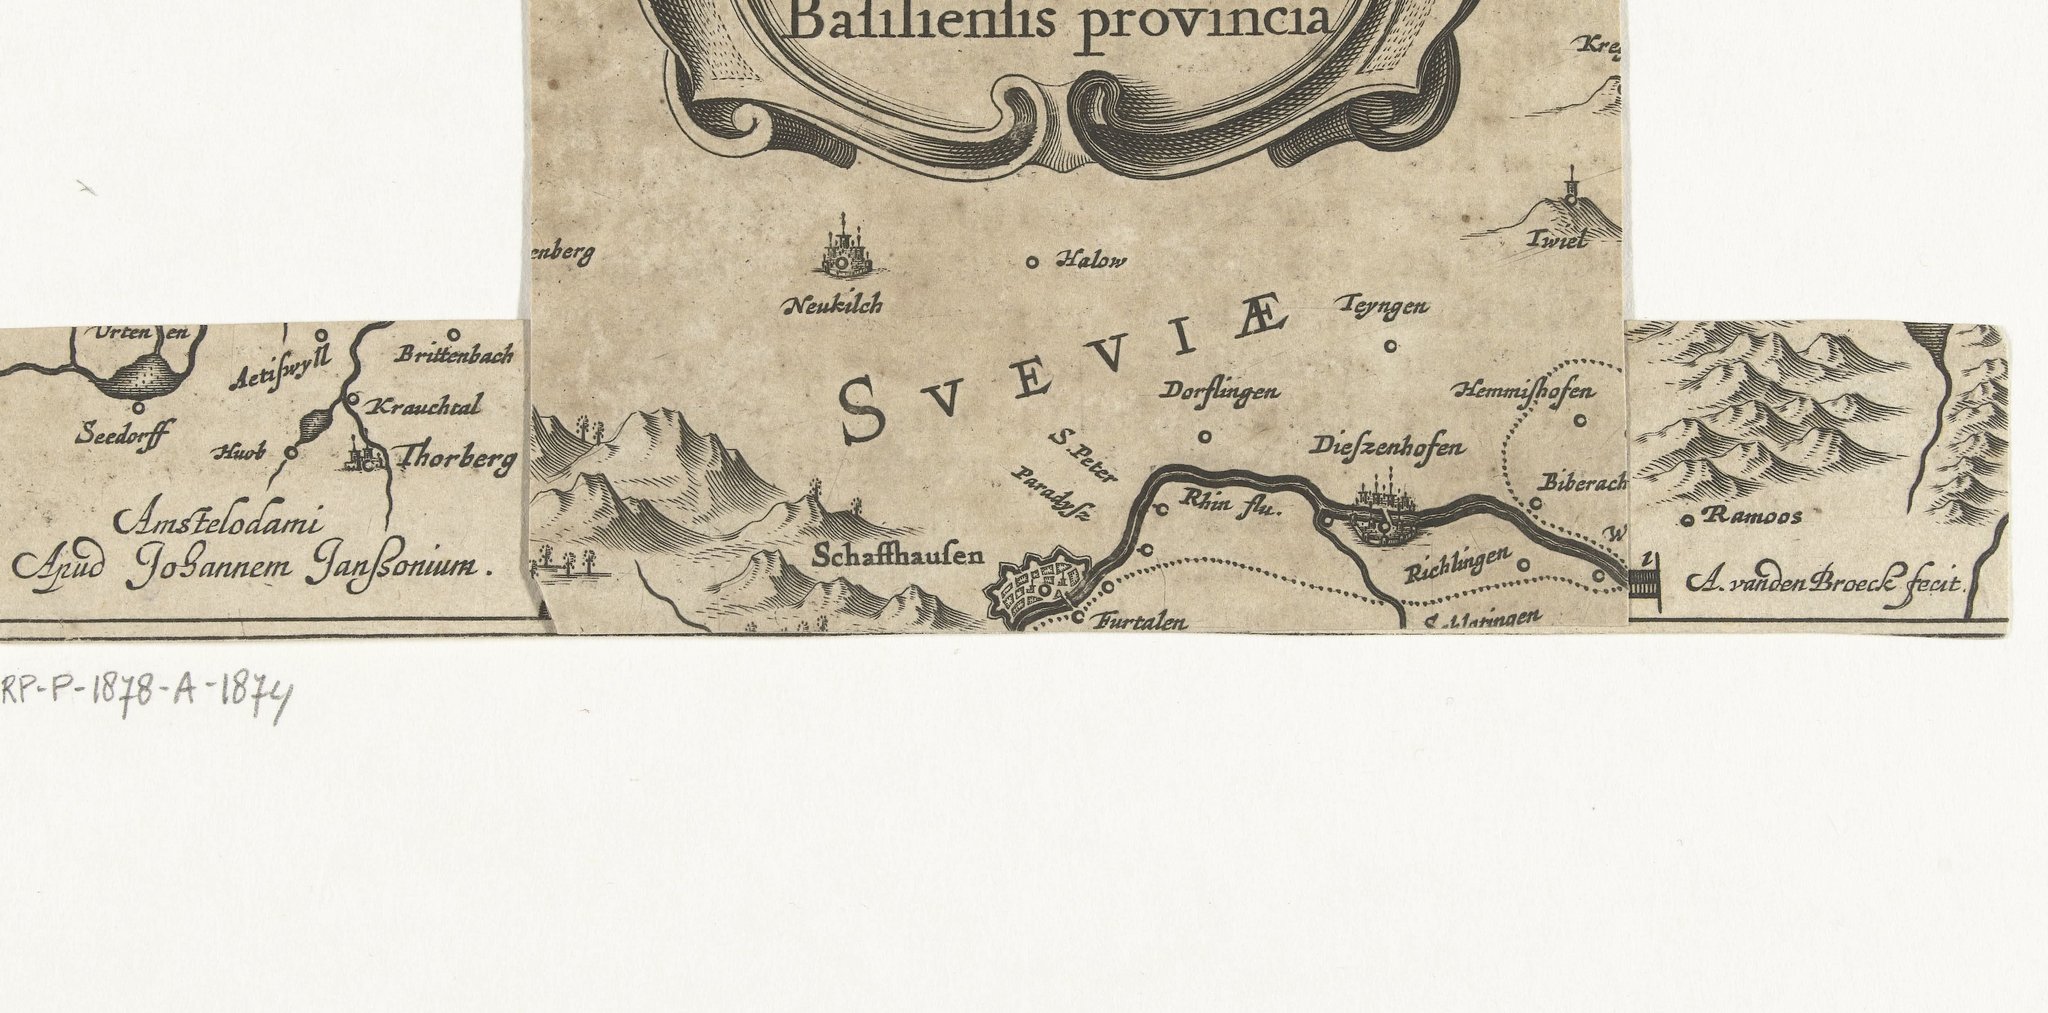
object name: print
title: Twee fragmenten van een kaart van de cantons Zürich en Basel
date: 1626-1665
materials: paper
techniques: engraving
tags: maps of cities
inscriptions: collector's mark: Lugt 2228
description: Twee fragmenten van een kaart van de cantons Zürich en Basel op elkaar geplakt.